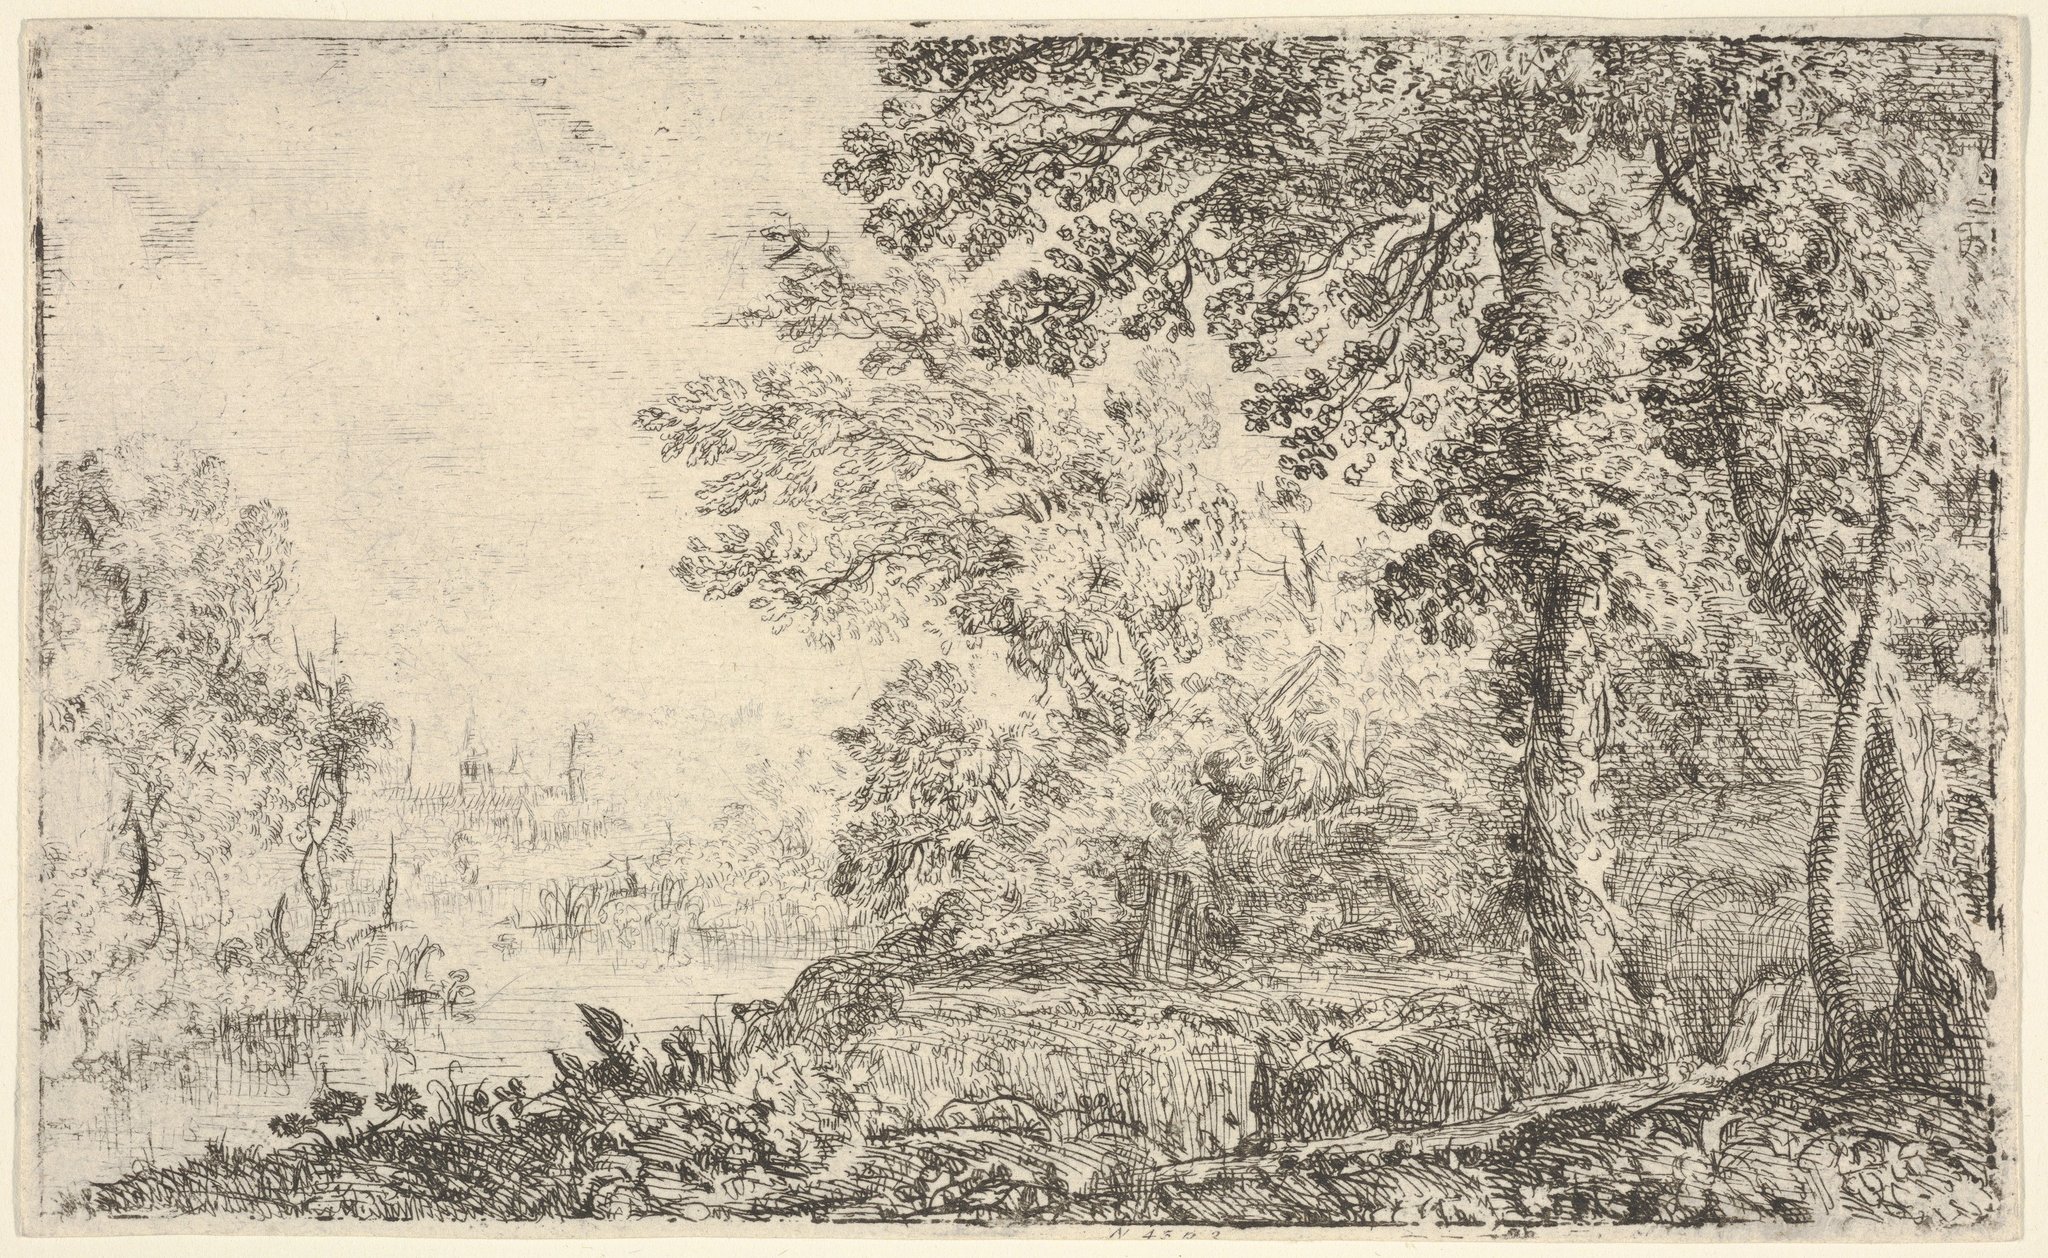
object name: print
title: A landscape with a monk and an angel in the center, a town to the left (The Vision)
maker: claude lorrain (claude gellée)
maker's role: artist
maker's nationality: french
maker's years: 1604-1682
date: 1630-1640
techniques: etching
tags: landscapes,trees,angels,monks